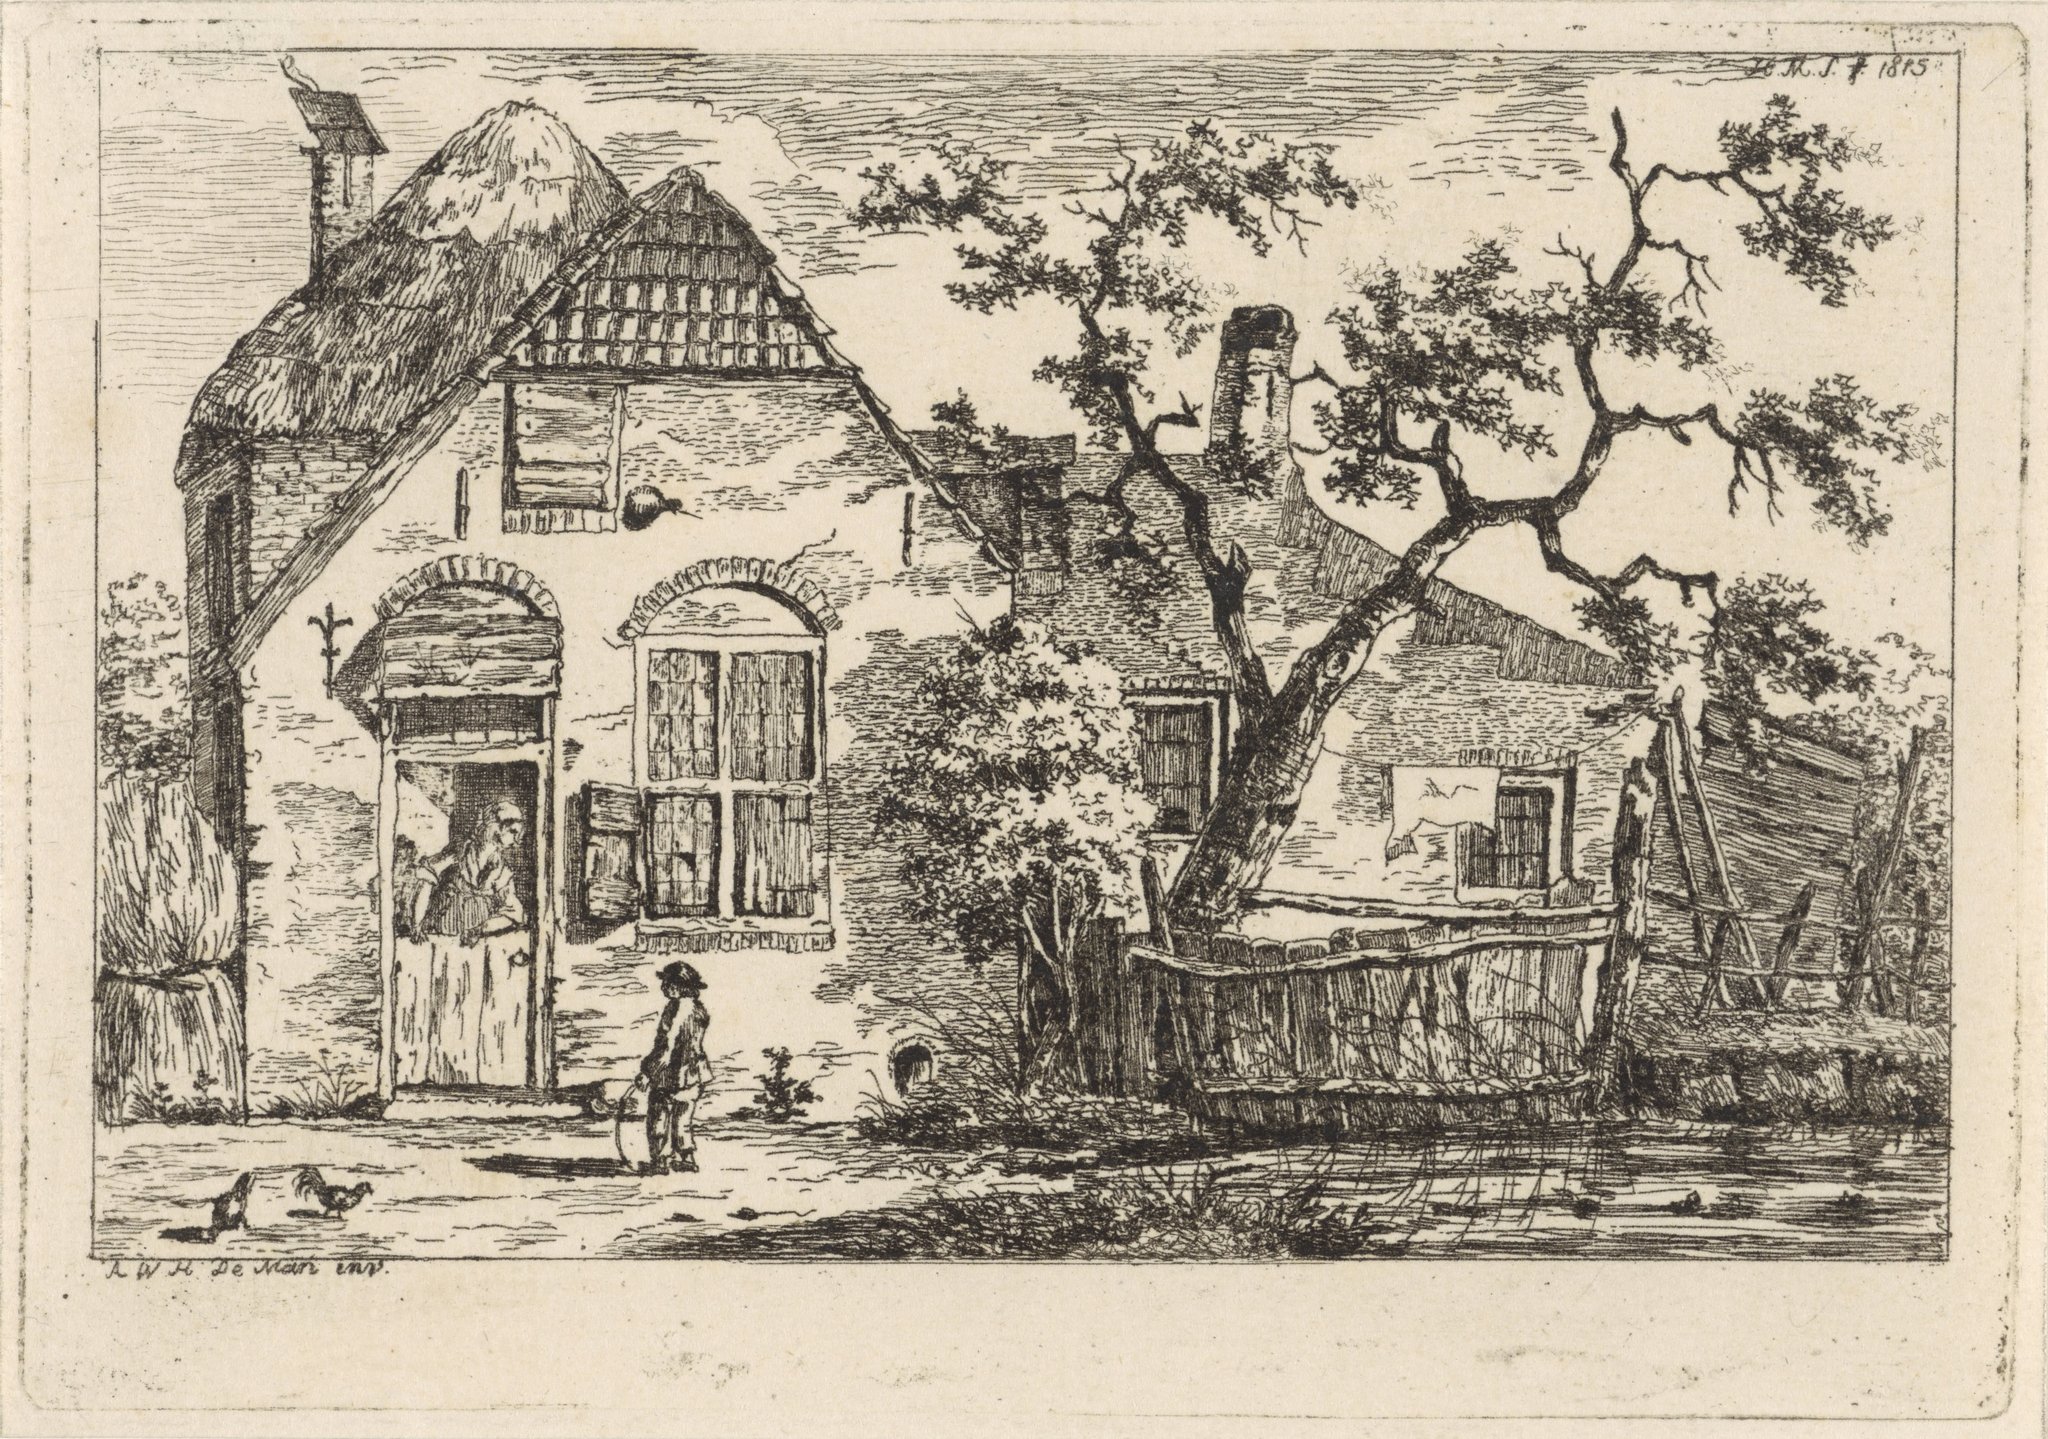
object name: print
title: Jongen met hoepel bij een boerderij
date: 1815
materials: paper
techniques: etching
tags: (bowling a) hoop, farm or solitary house in landscape, accessories and implements ~ laundering, e.g. clothes-peg, drying frame, (empty) washing line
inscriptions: collector's mark: Lugt 2228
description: De jongen met de hoepel voor het huis. In de deur der woning staat eene vrouw, op den voorgrond links twee kippen. In het marge: A.W.H. De Man inv. In den r.b.h. H.M.S. f. 1815